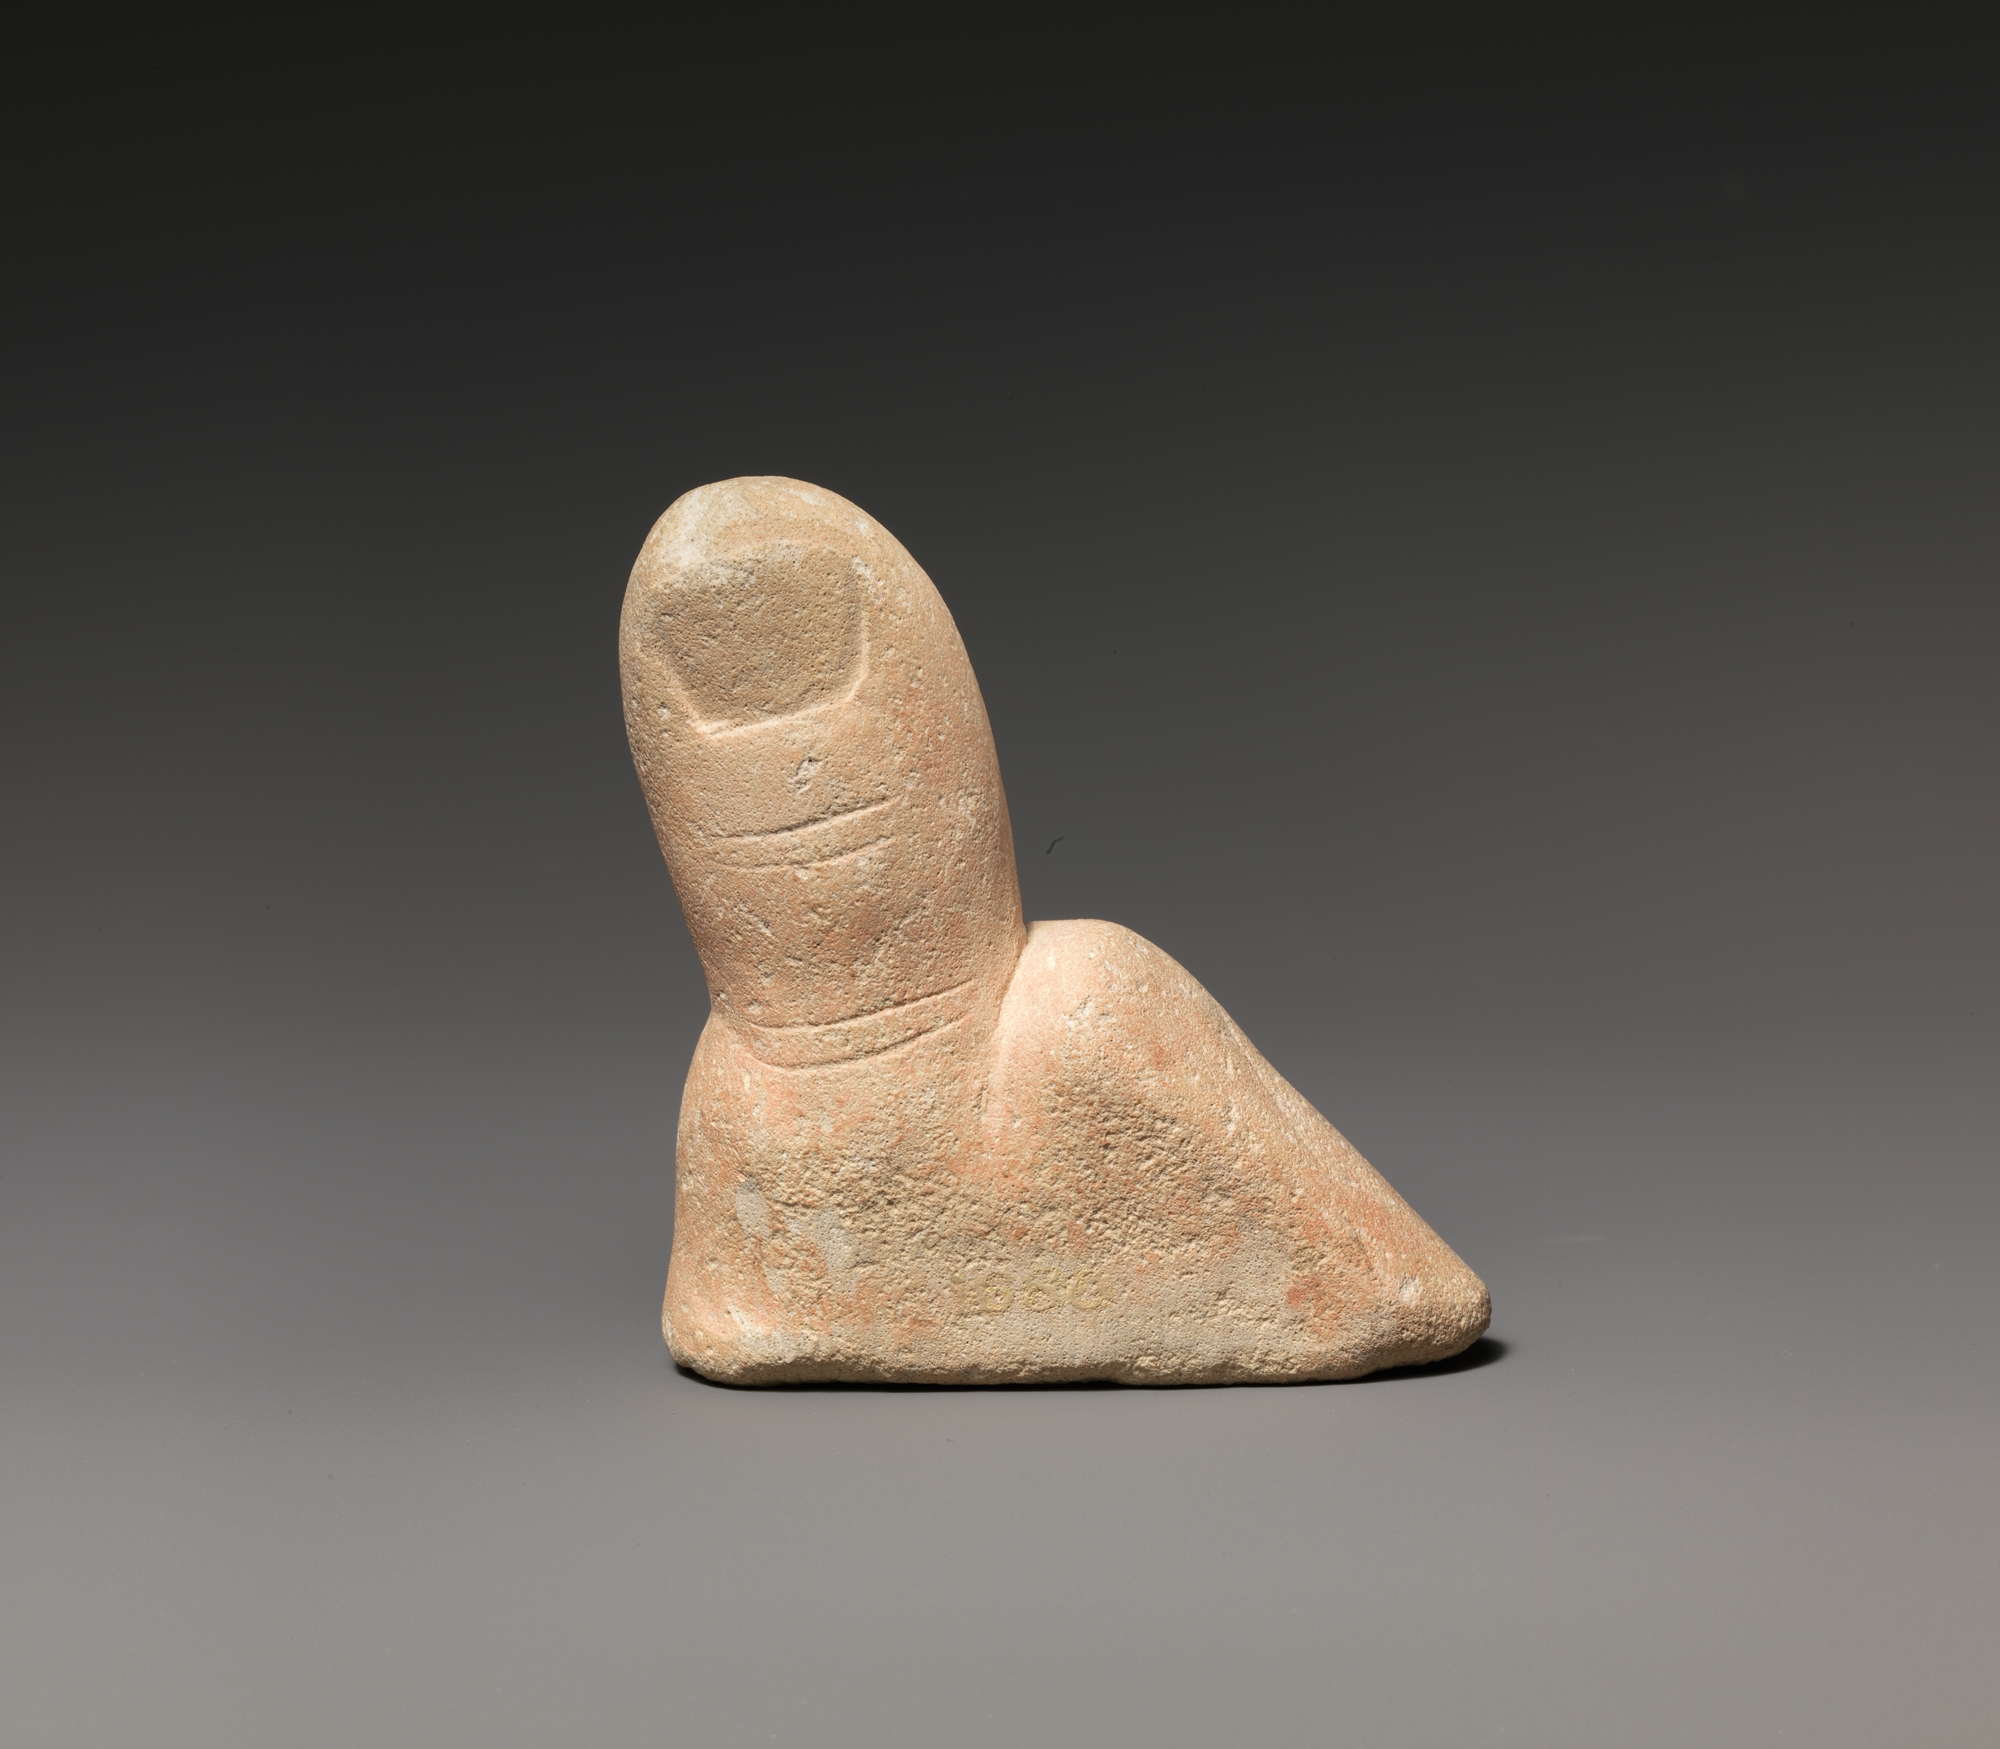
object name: votive toe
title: Limestone votive toe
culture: cypriot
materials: limestone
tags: feet